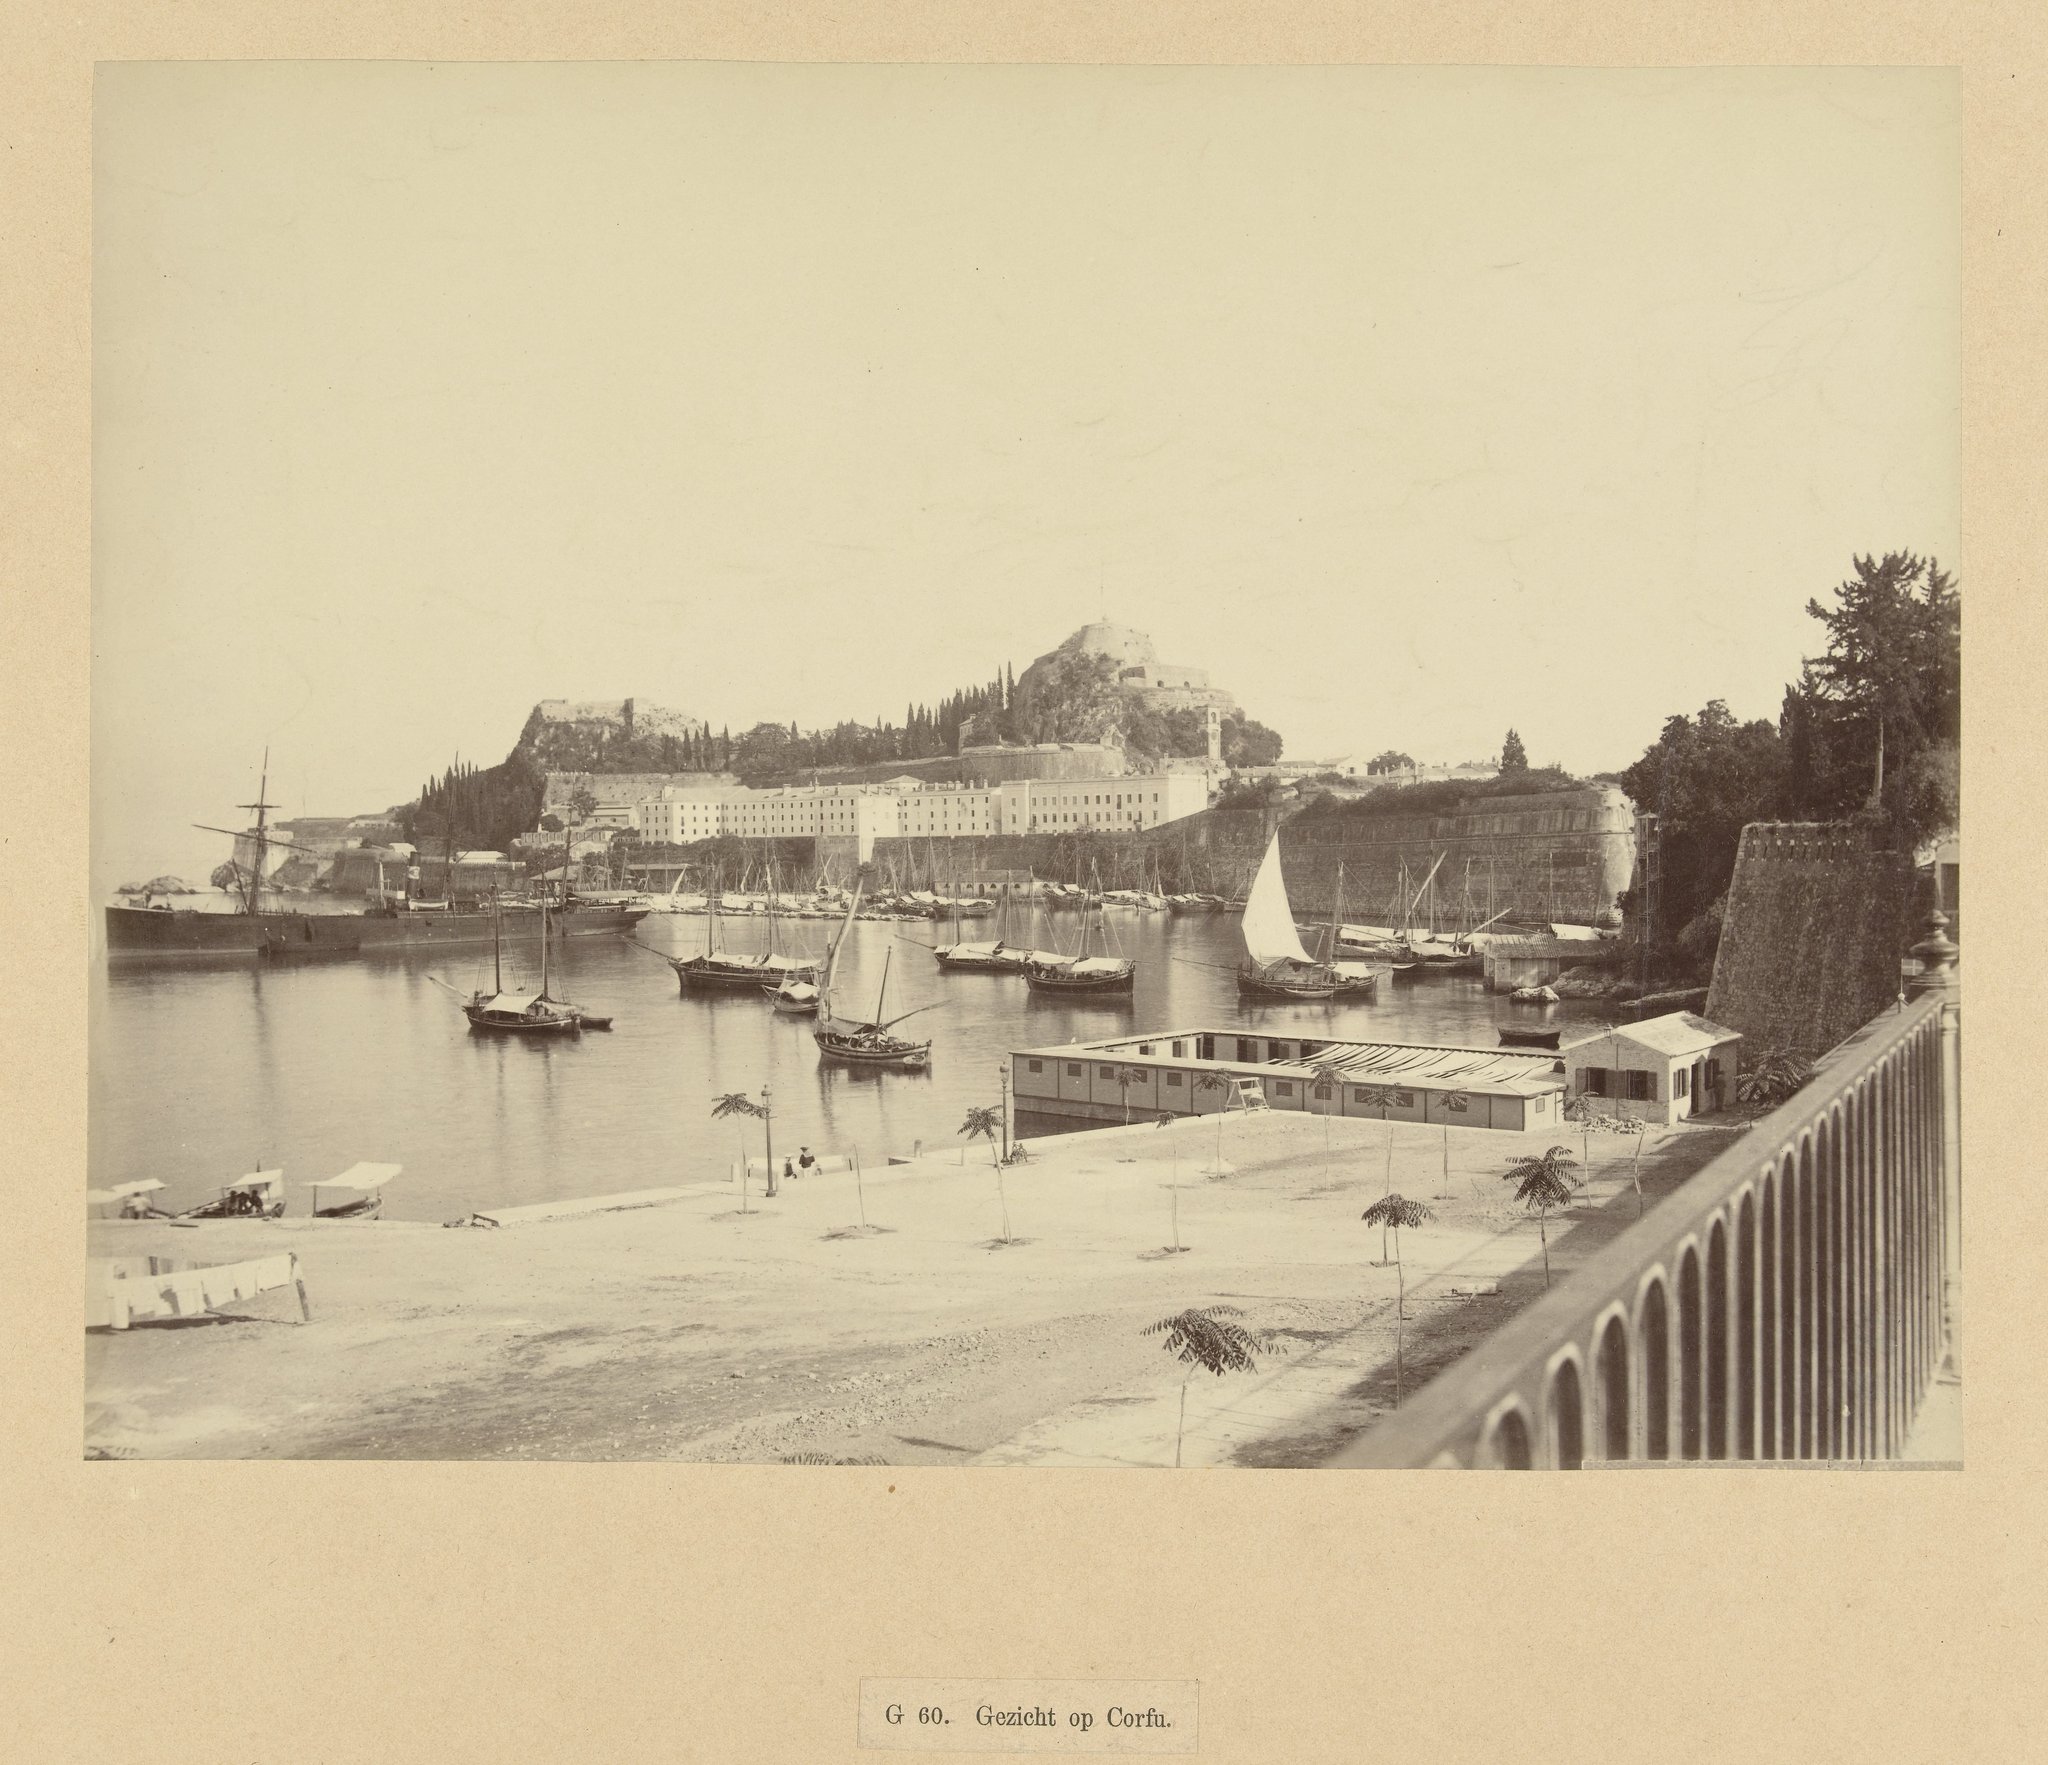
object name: photograph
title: Gezicht op de haven van Korfoe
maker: Anonymous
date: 1890-1895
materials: cardboard, paper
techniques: albumen print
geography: corfu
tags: harbour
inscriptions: title: ‘G 60. Gezicht op Corfu.’, stamp: ‘Gemeentelijke bibliotheek/ Rotterdam’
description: Onderdeel van een groep door fotograaf Richard Polak op reis verzamelde foto’s. Deze foto is samen met andere op zijn reizen verzamelde foto's tentoongesteld bij de Rotterdamsche Kunstkring (1895), Arti en Amicitiae te Amsterdam (1897-1898?) en Societeit 't Collegie te Kampen (datum vooralsnog onbekend).